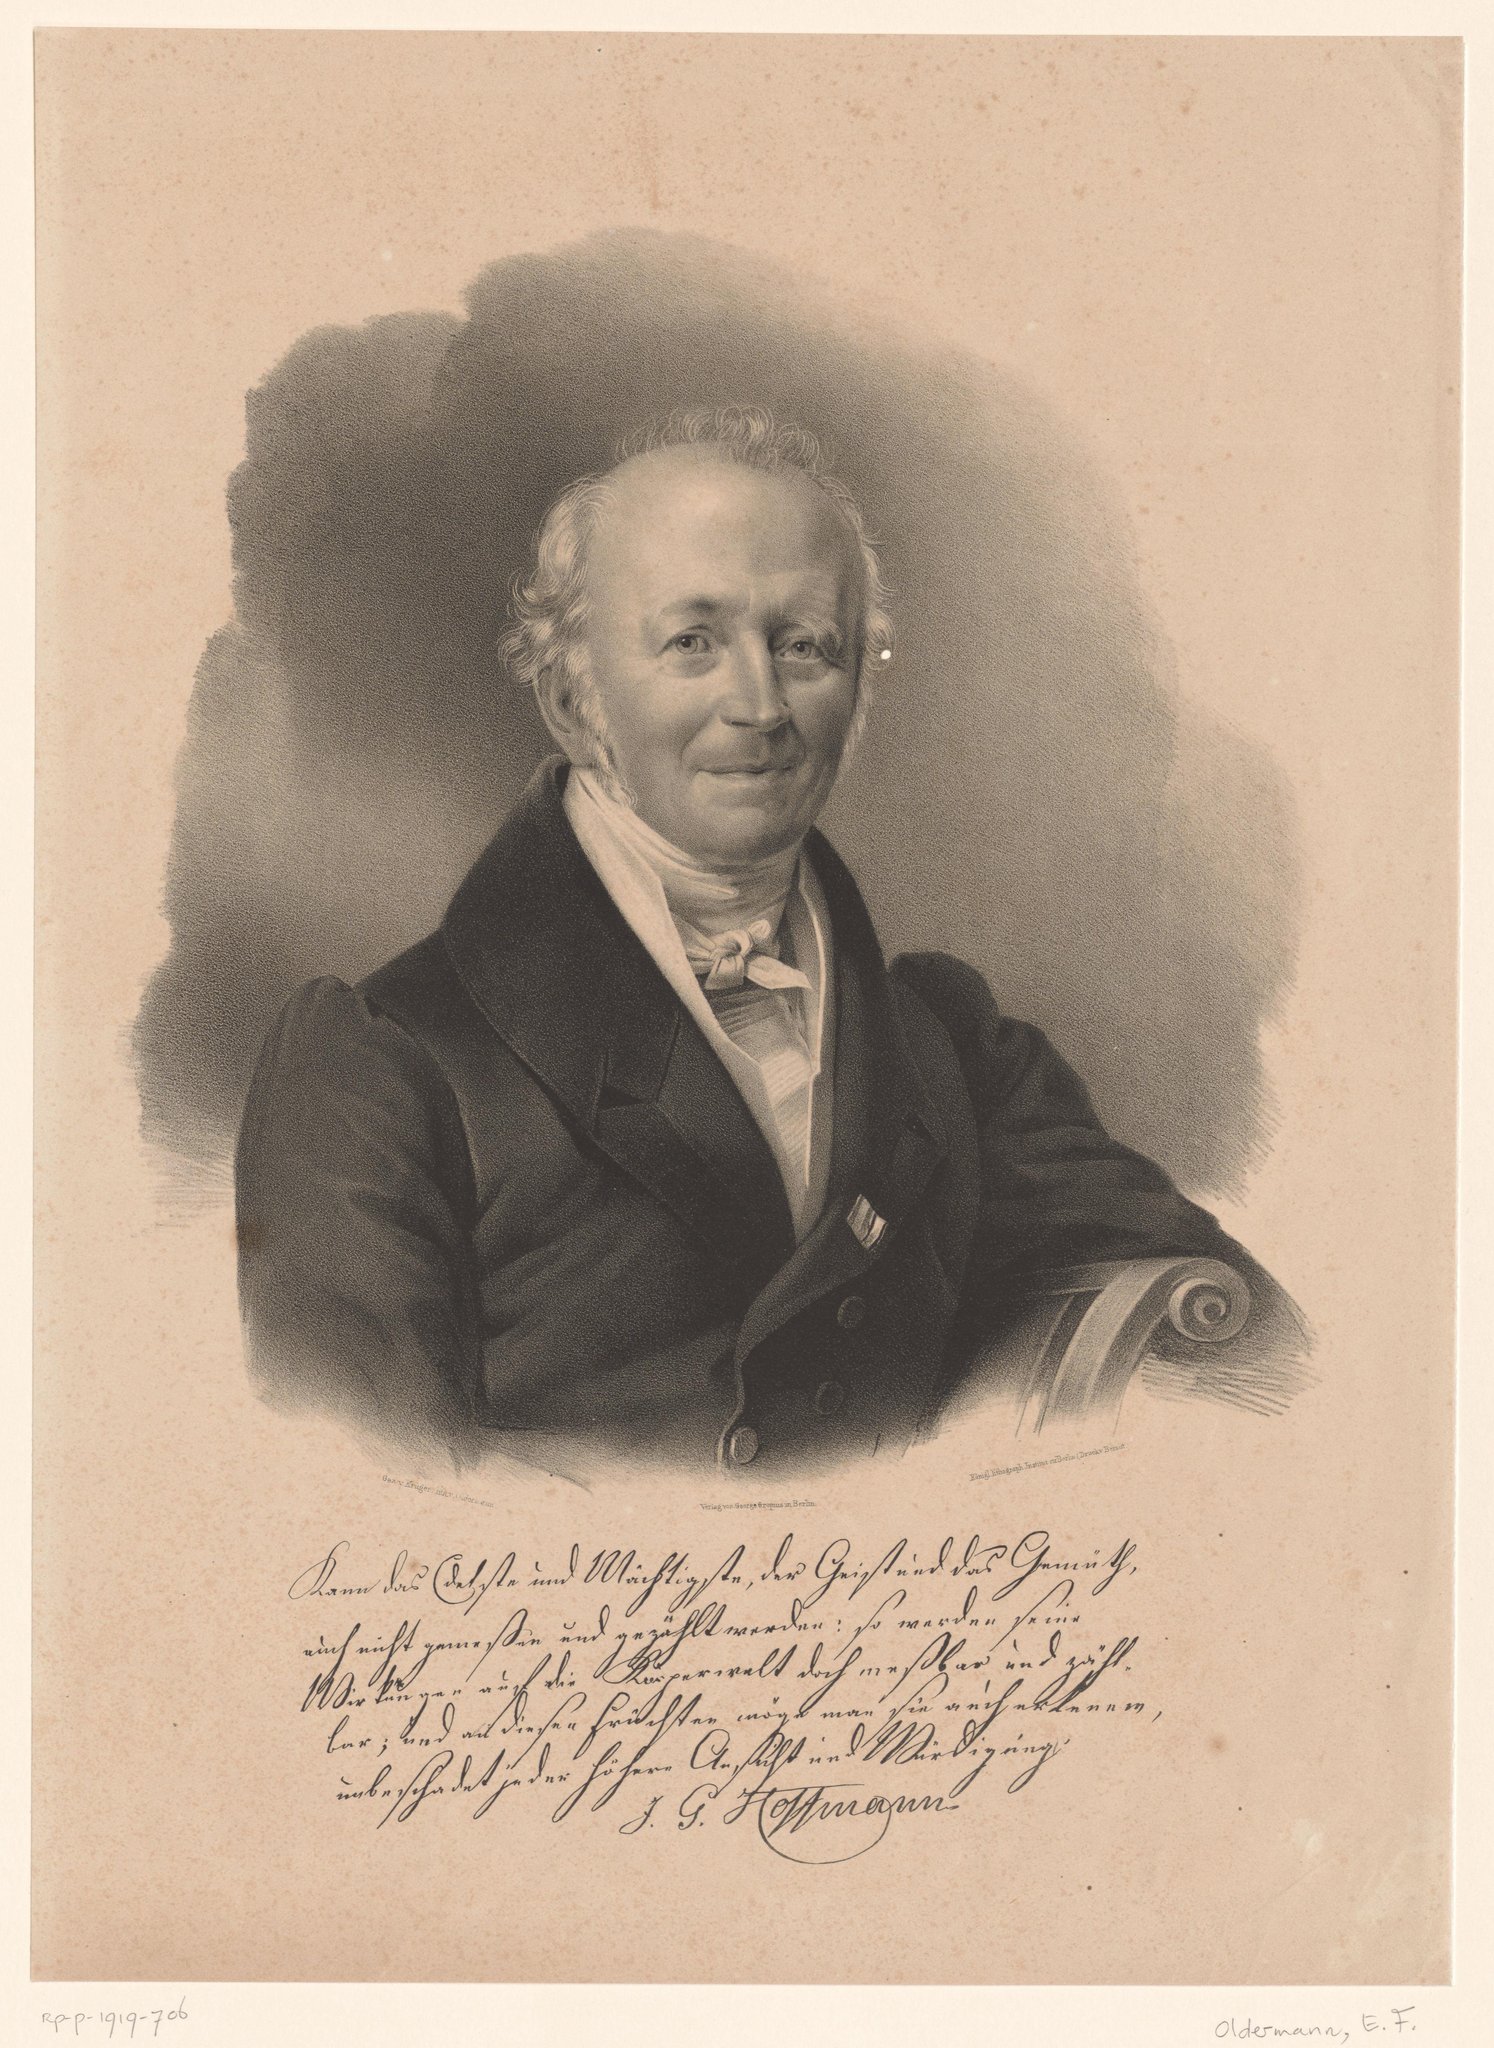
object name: print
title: Portret van Johann Gottfried Hoffmann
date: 1818-1842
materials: paper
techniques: lithograph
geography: berlin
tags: berlin, scholar, philosopher, historical persons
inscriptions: collector's mark: Lugt 2228